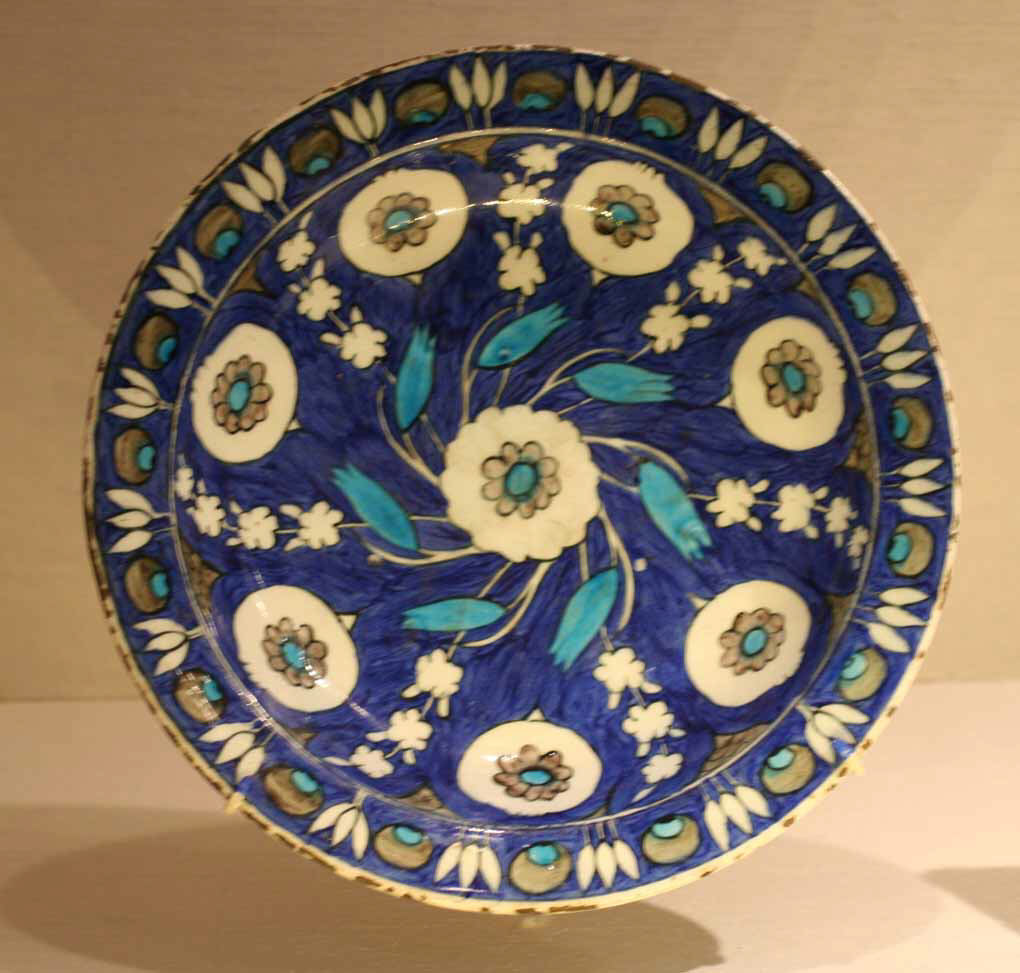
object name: dish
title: Blue-Ground Dish with Floral Design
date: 1550-1560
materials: glaze, stonepaste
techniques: painting, polychrome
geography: turkey